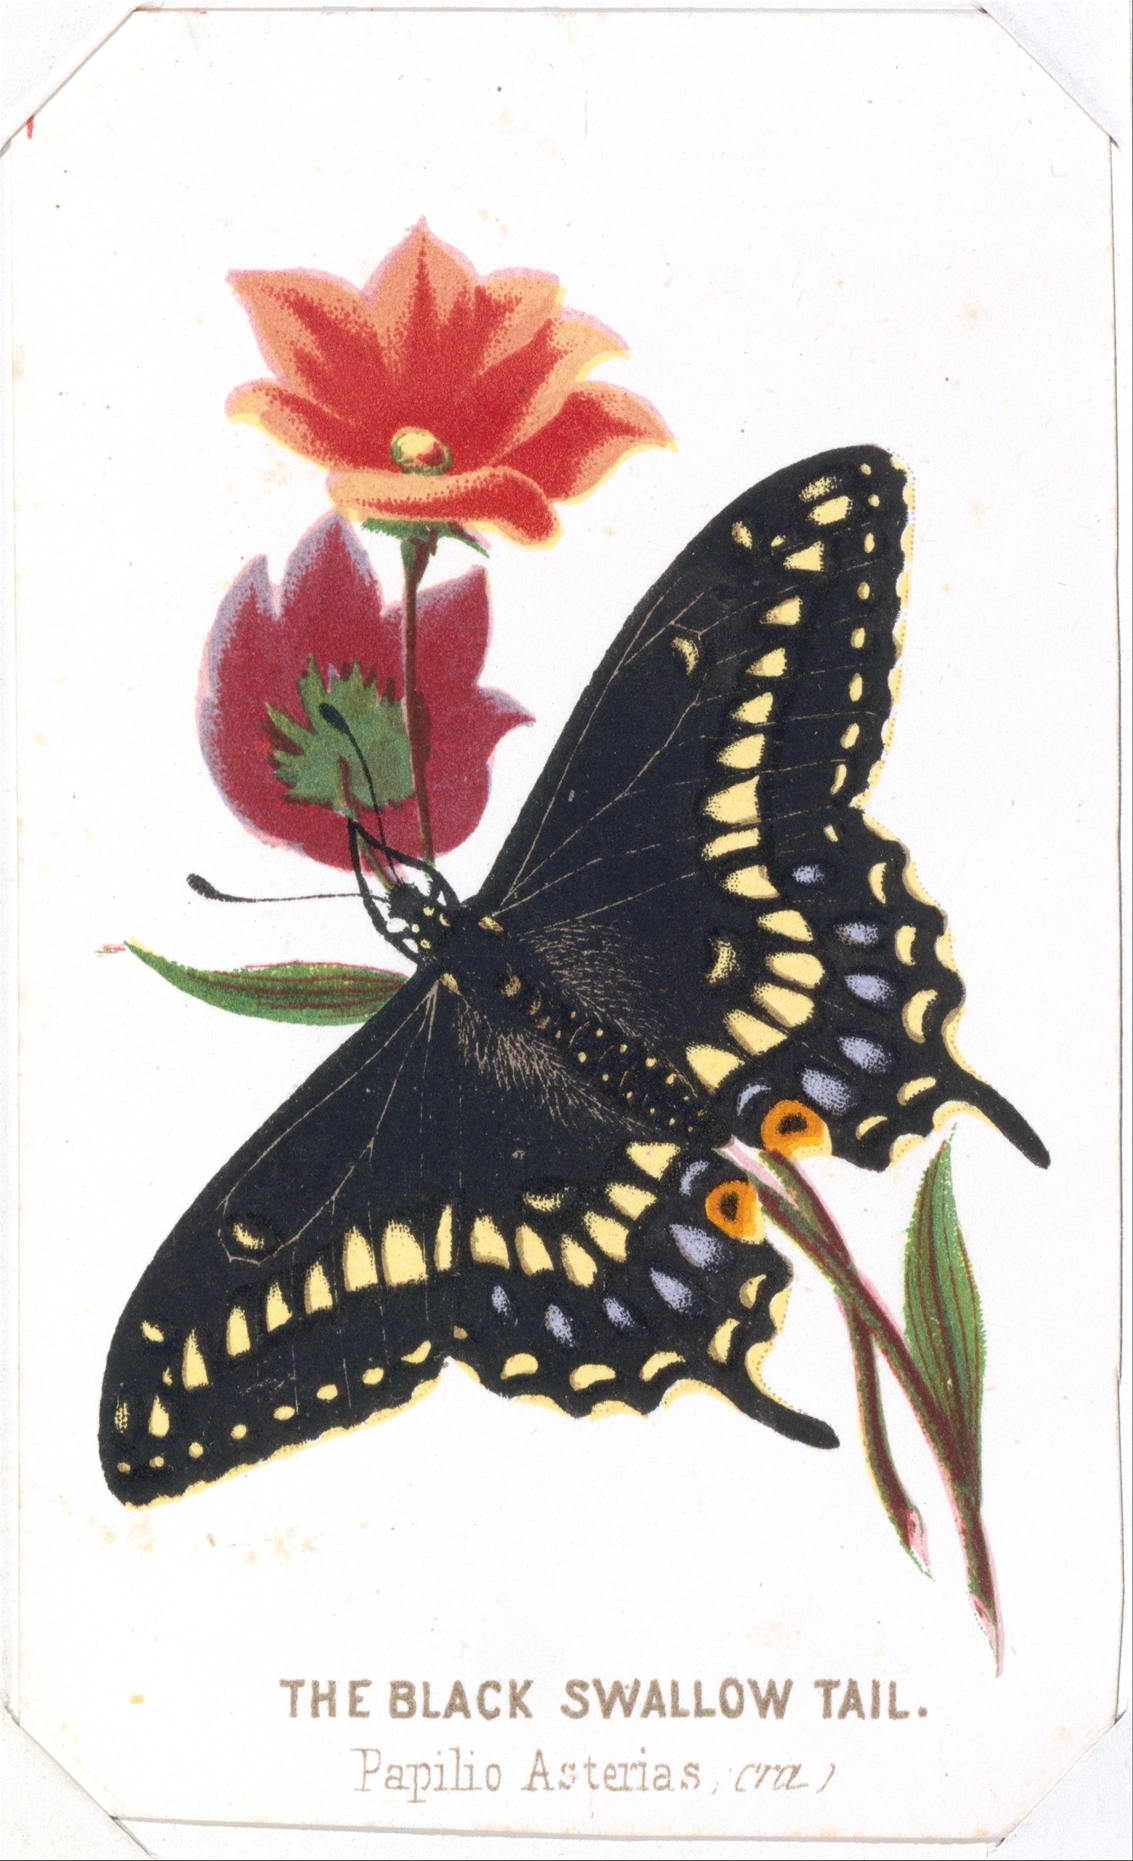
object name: print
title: The Black Swallowtail from The Butterflies and Moths of America Part 3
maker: louis prang & co.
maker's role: publisher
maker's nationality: american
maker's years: 1800-1950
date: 1862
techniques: lithograph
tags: butterflies